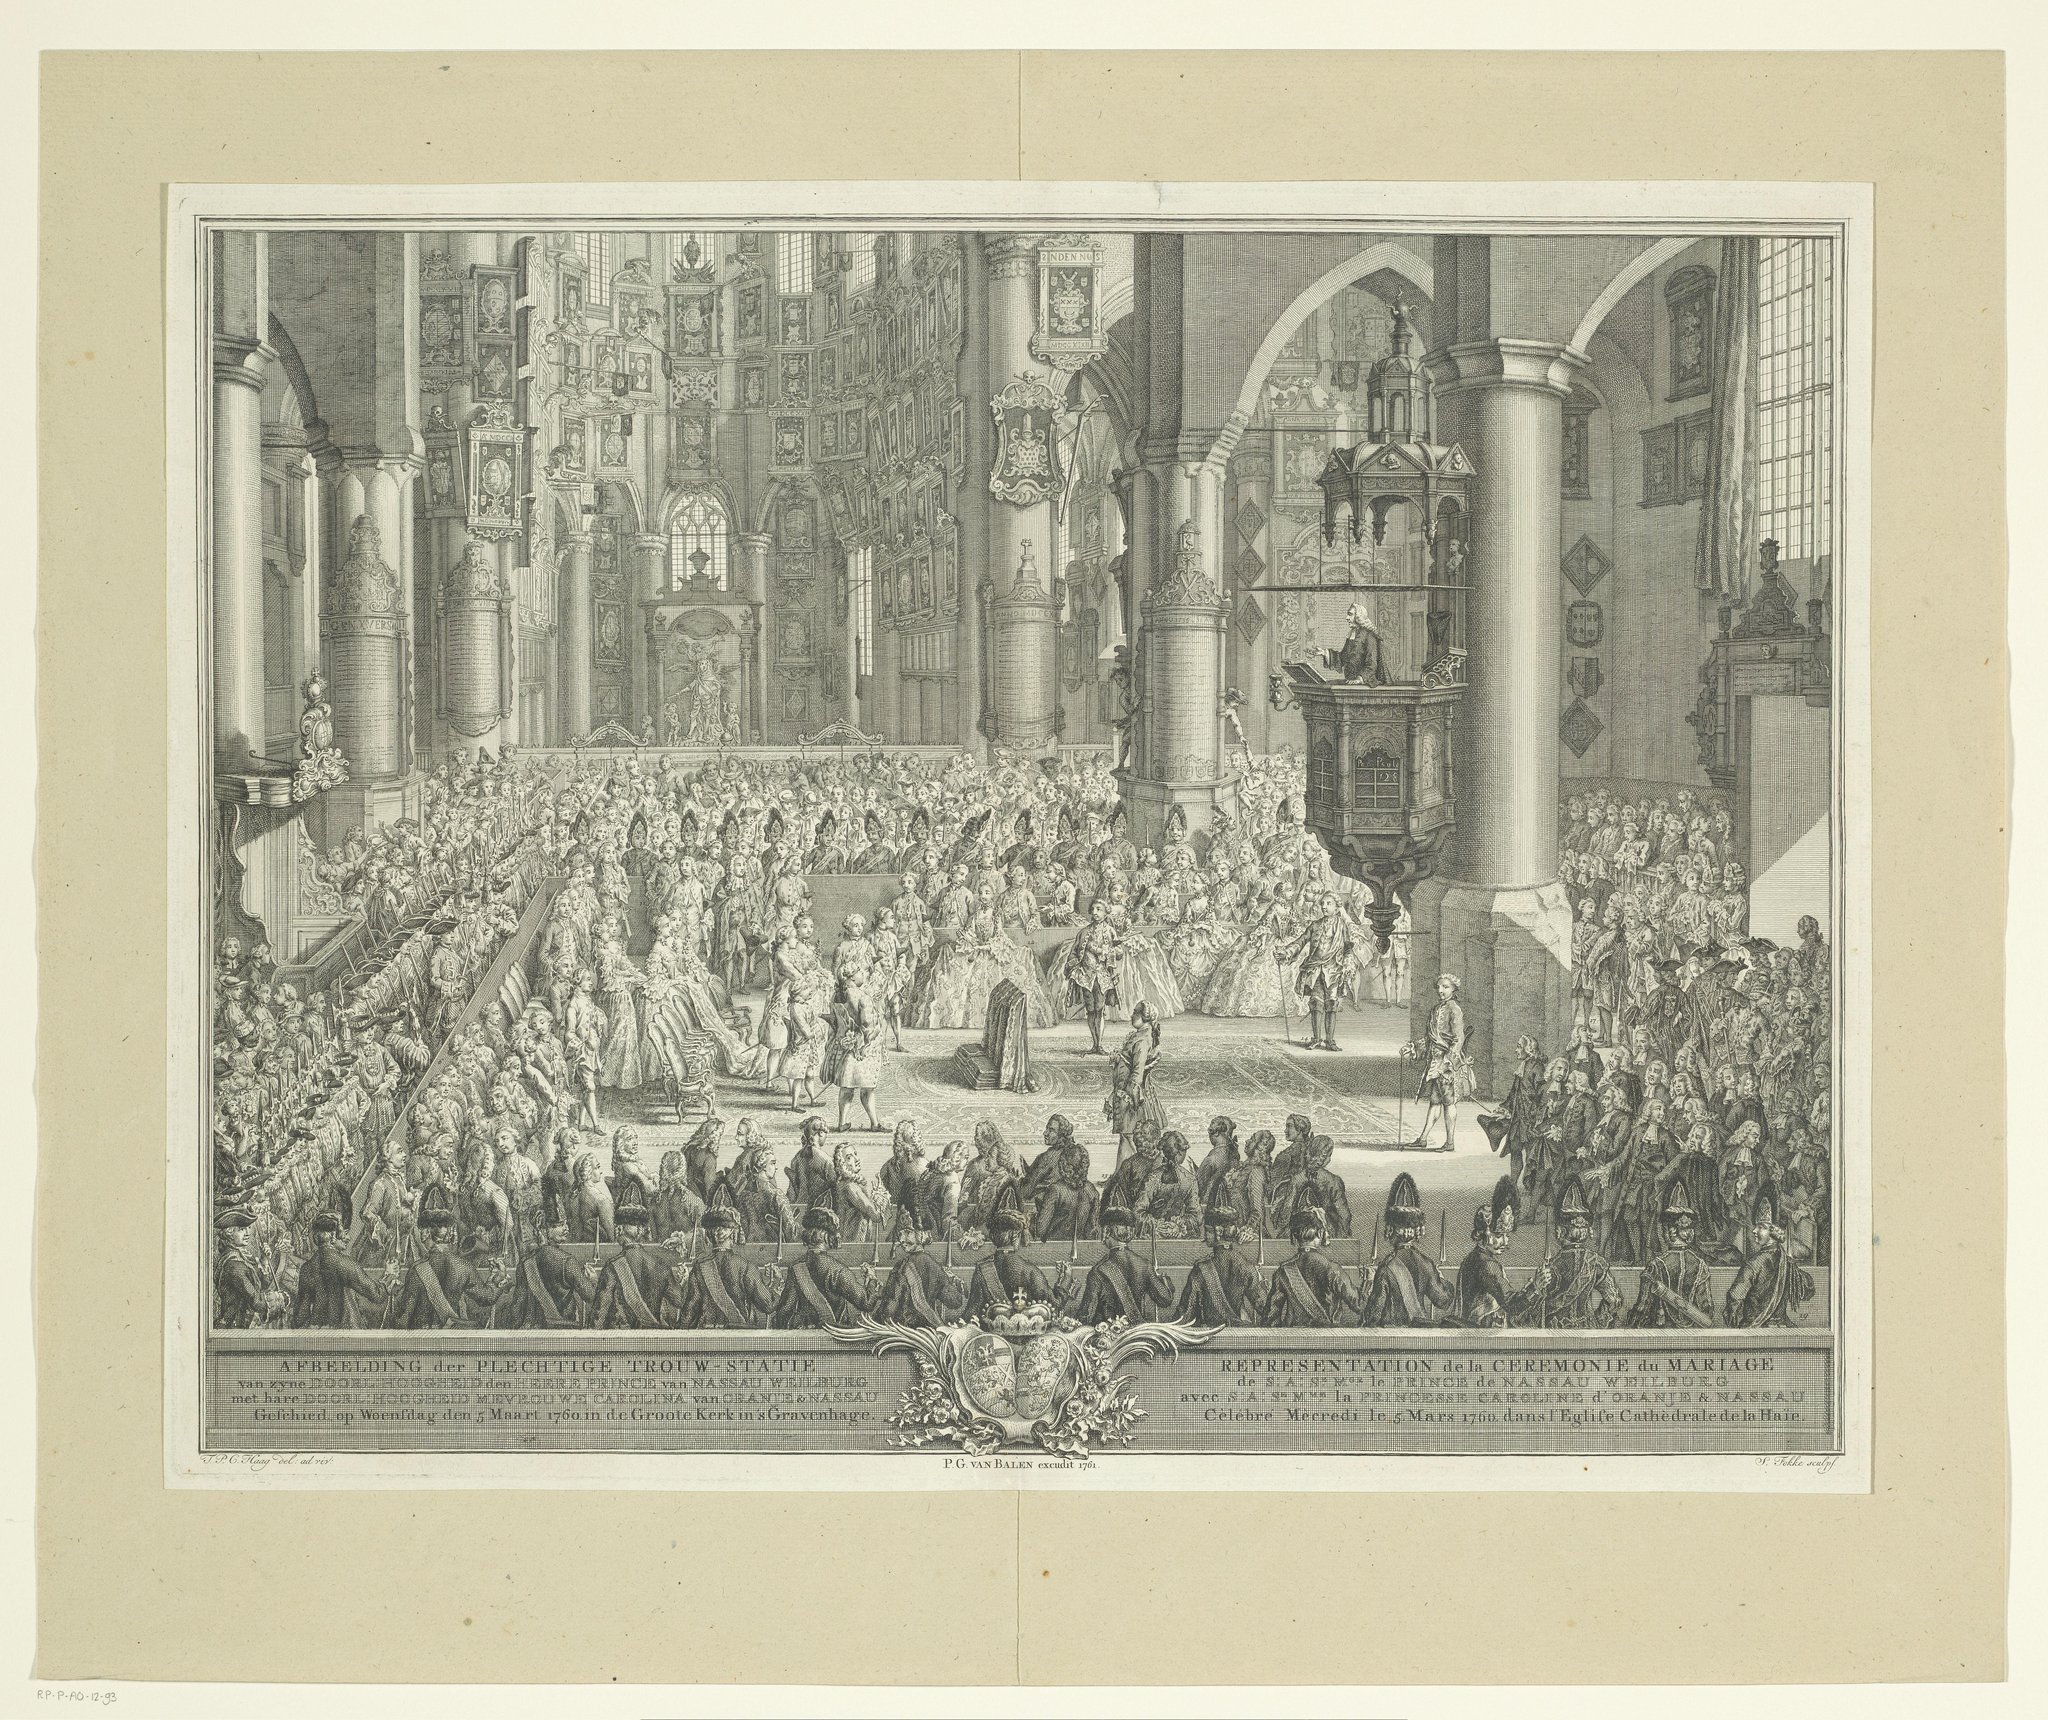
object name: print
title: Huwelijk van Karel Christiaan van Nassau-Weilburg met prinses Carolina, 1760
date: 1761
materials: paper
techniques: engraving, etching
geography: amsterdam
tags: william v (prince of orange), ludwig ernst von braunschweig-wolfenbüttel, carolina (prinses van oranje-nassau), karel christiaan vorst van nassau-weilburg, marriage ~ protestant service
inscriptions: date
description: Huwelijksceremonie van Karel Christiaan van Nassau-Weilburg met prinses Carolina, 5 maart 1760. Interieur van de Grote Kerk te Den Haag met alle gasten, de dominee spreekt het paar toe. Bij het bruidspaar staat de jonge prins Willem V met zijn voogd, de hertog van Brunswijk. Onderaan de wapens van het bruidspaar. Bij de prent behoort een tekstblad.